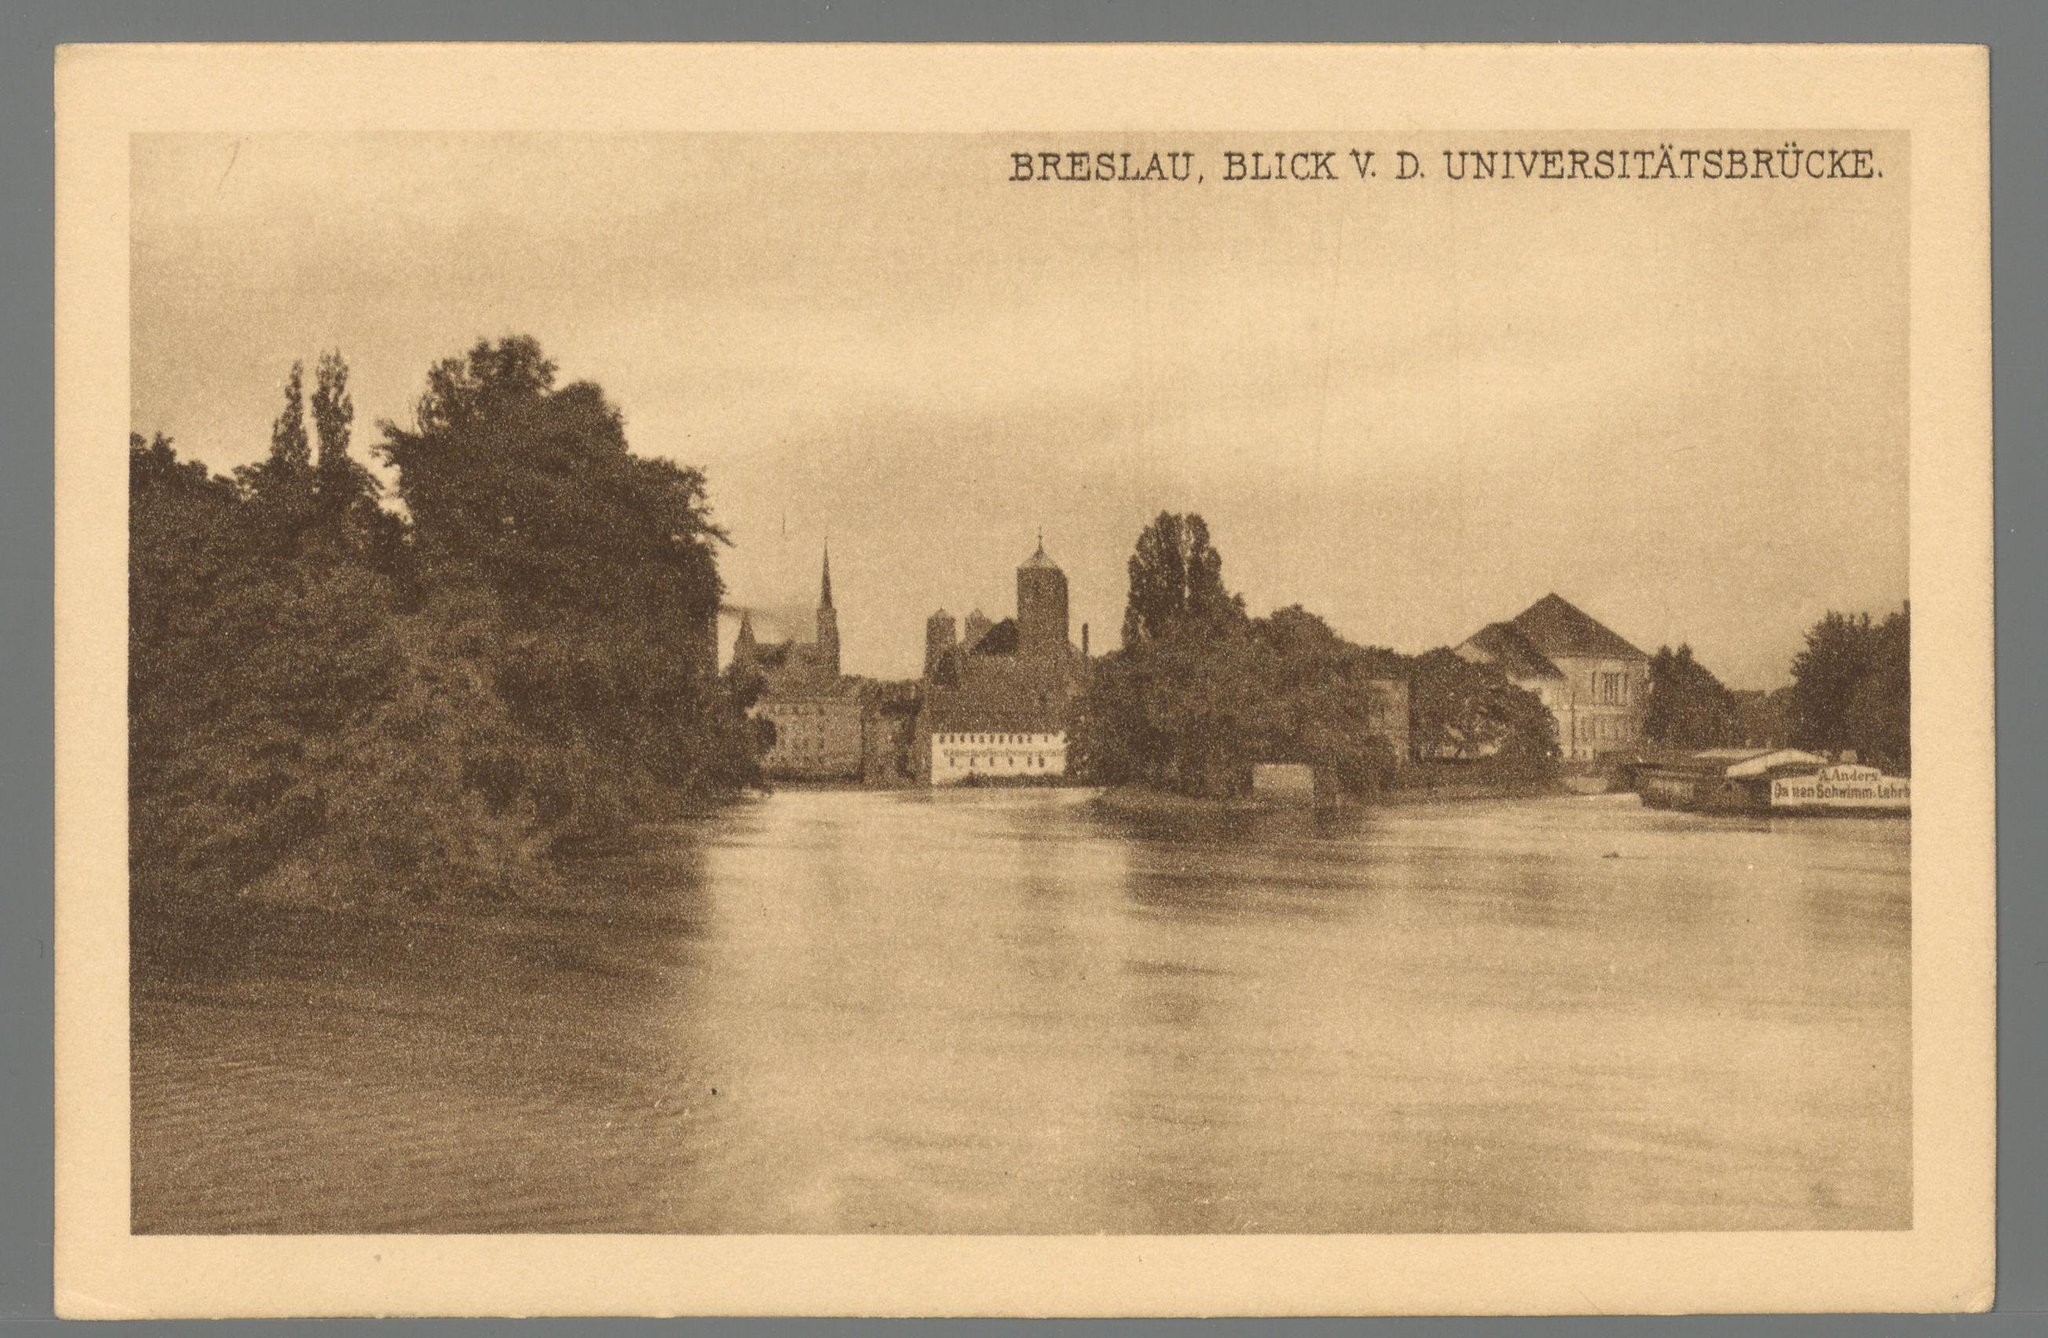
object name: ansichtkaart, prentbriefkaart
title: Breslau, blick v.d. Universitätsbrücke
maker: Anonymous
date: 1905-1930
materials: cardboard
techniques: rotogravure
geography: breslau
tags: river, university building, college